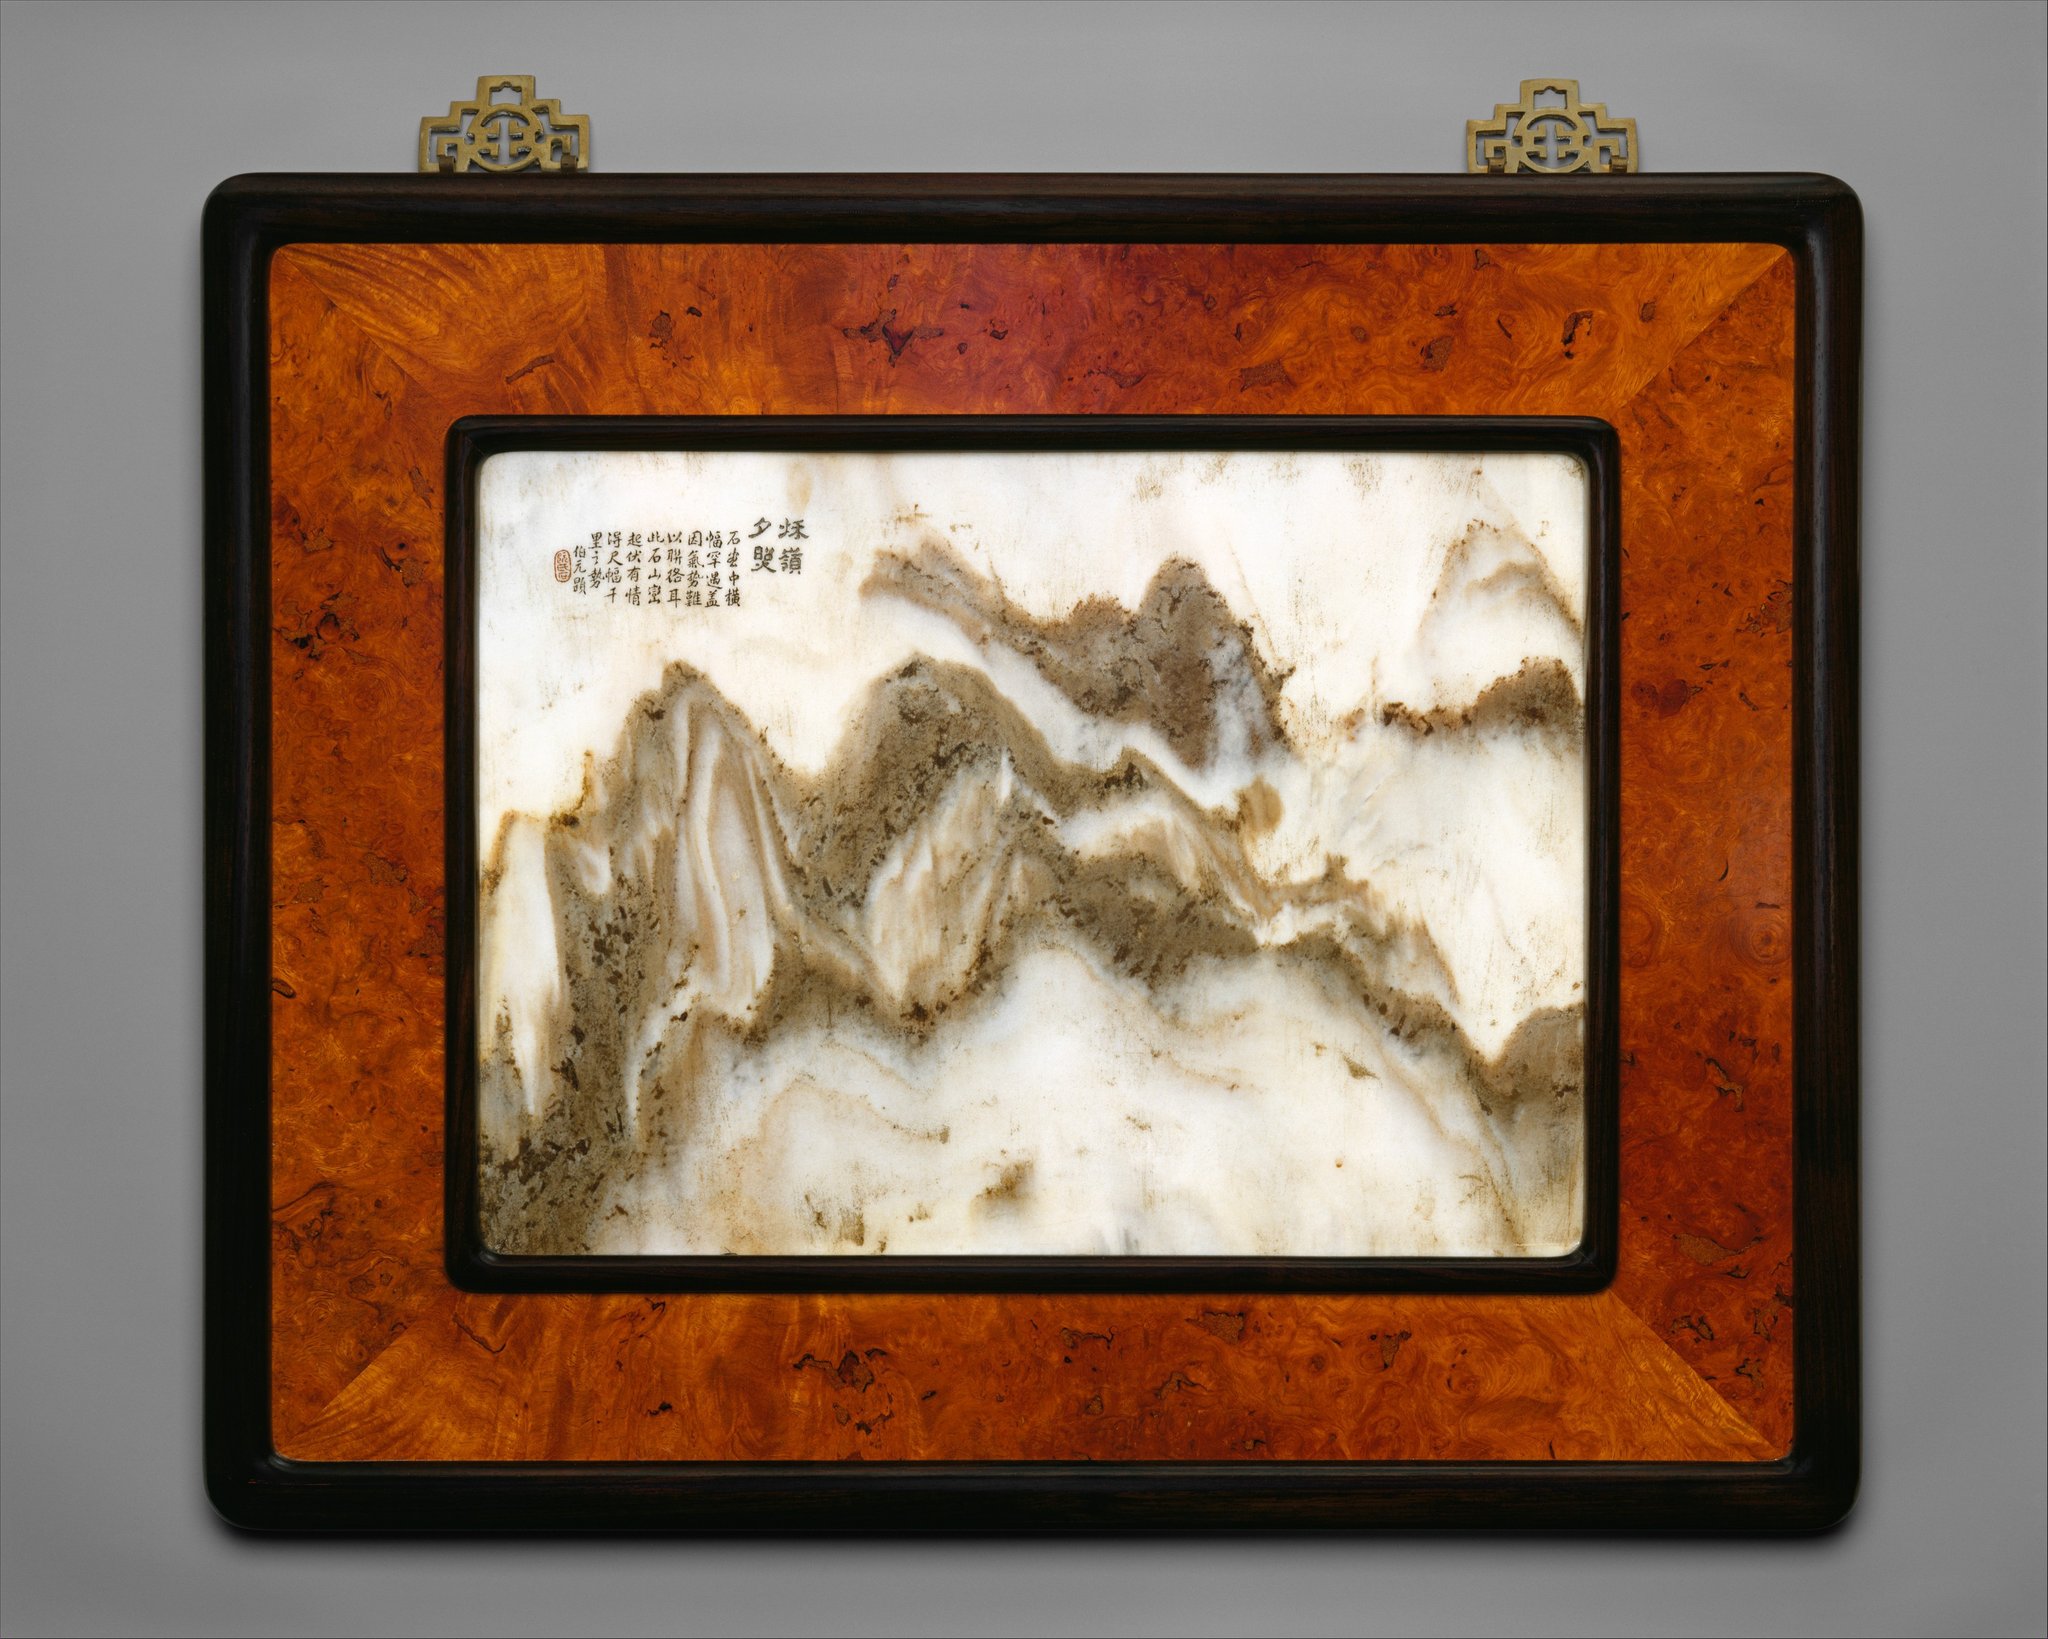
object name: table screen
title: Table screen, converted to a wall panel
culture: chinese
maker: ruan yuan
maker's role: artist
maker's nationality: chinese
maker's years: 1764-1849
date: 1801-1900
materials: marble, wood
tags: mountains